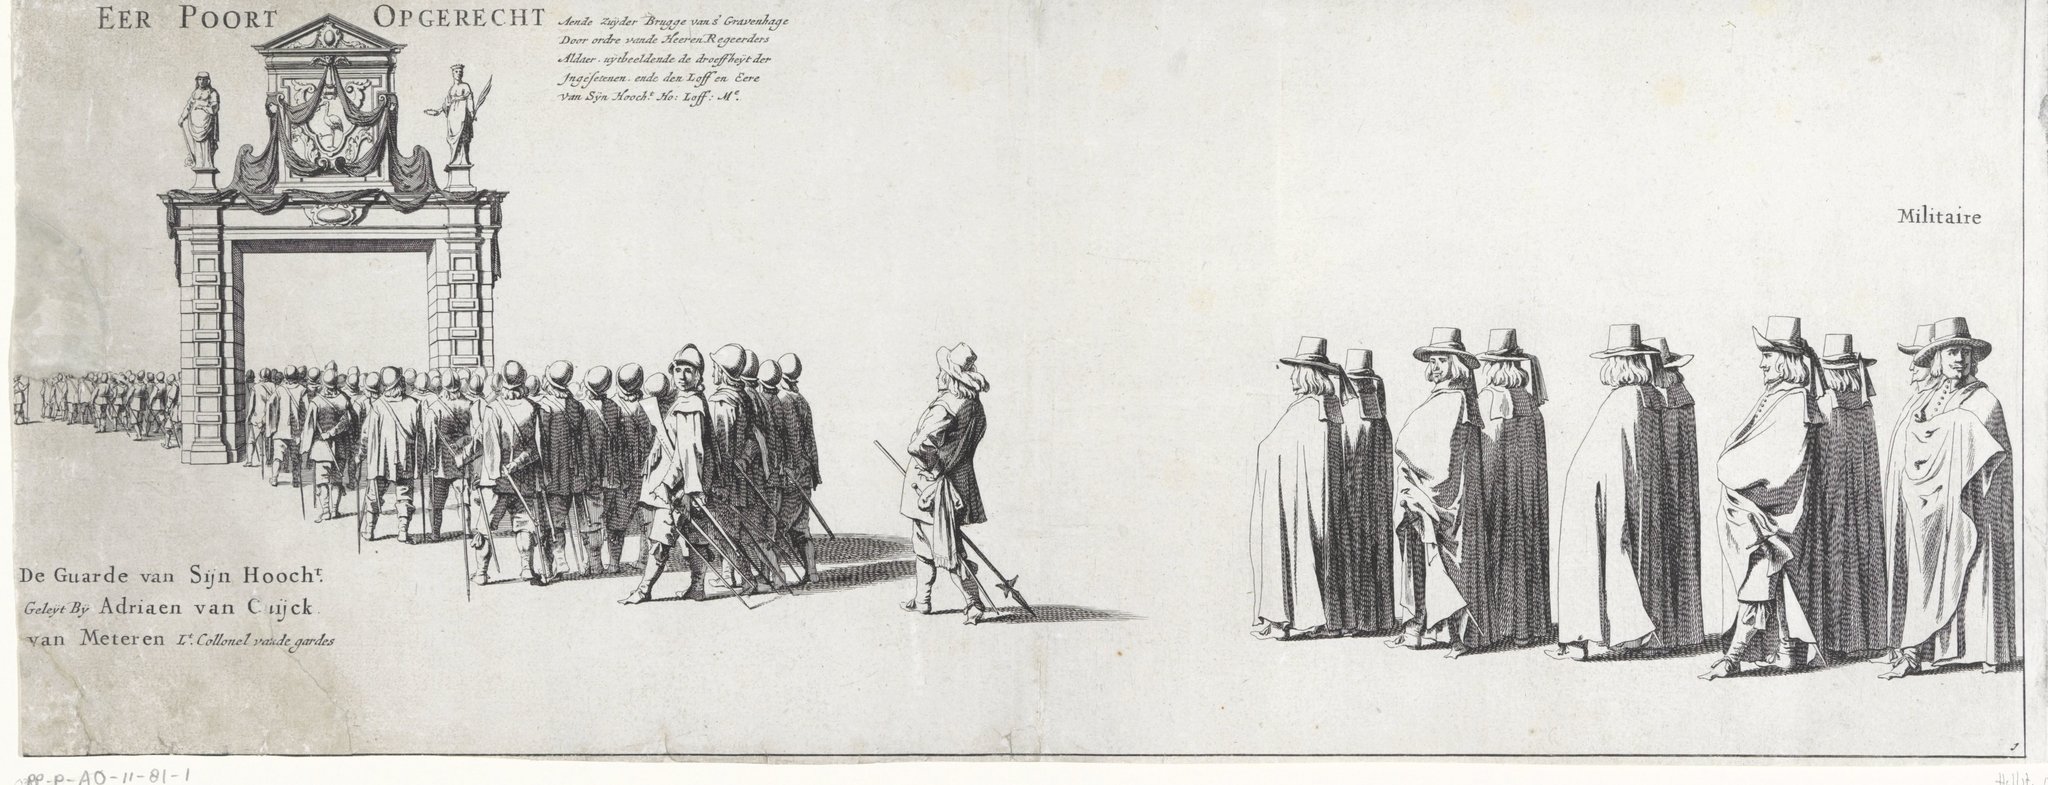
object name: print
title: De begrafenisstoet van stadhouder Frederik Hendrik te 's-Gravenhage in 1647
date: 1651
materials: paper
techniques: engraving, etching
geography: amsterdam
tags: cortege, funeral procession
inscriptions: collector's mark: Lugt 2228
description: De begrafenisstoet van stadhouder Frederik Hendrik te 's-Gravenhage op 10 mei 1647. Plaat nr. 1 met het voorste deel van de stoet dat door een erepoort trekt. Onderdeel van een serie van 30 platen en 20 tekstbladen, bedoeld om aan elkaar geplakt te worden.